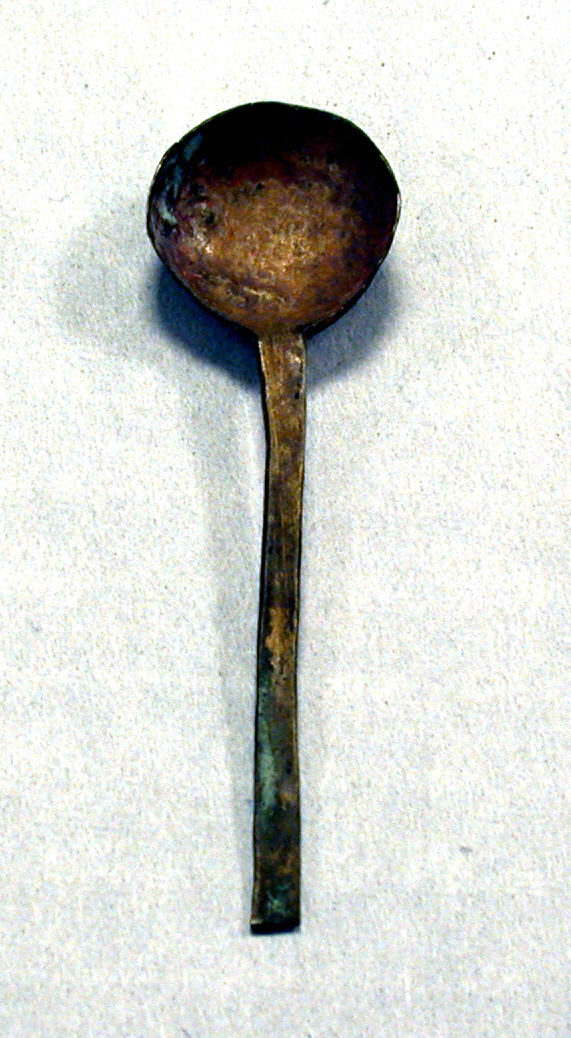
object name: spoon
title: Hammered Silver Spoon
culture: peruvian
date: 701-1566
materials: gilt, silver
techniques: hammering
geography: peru